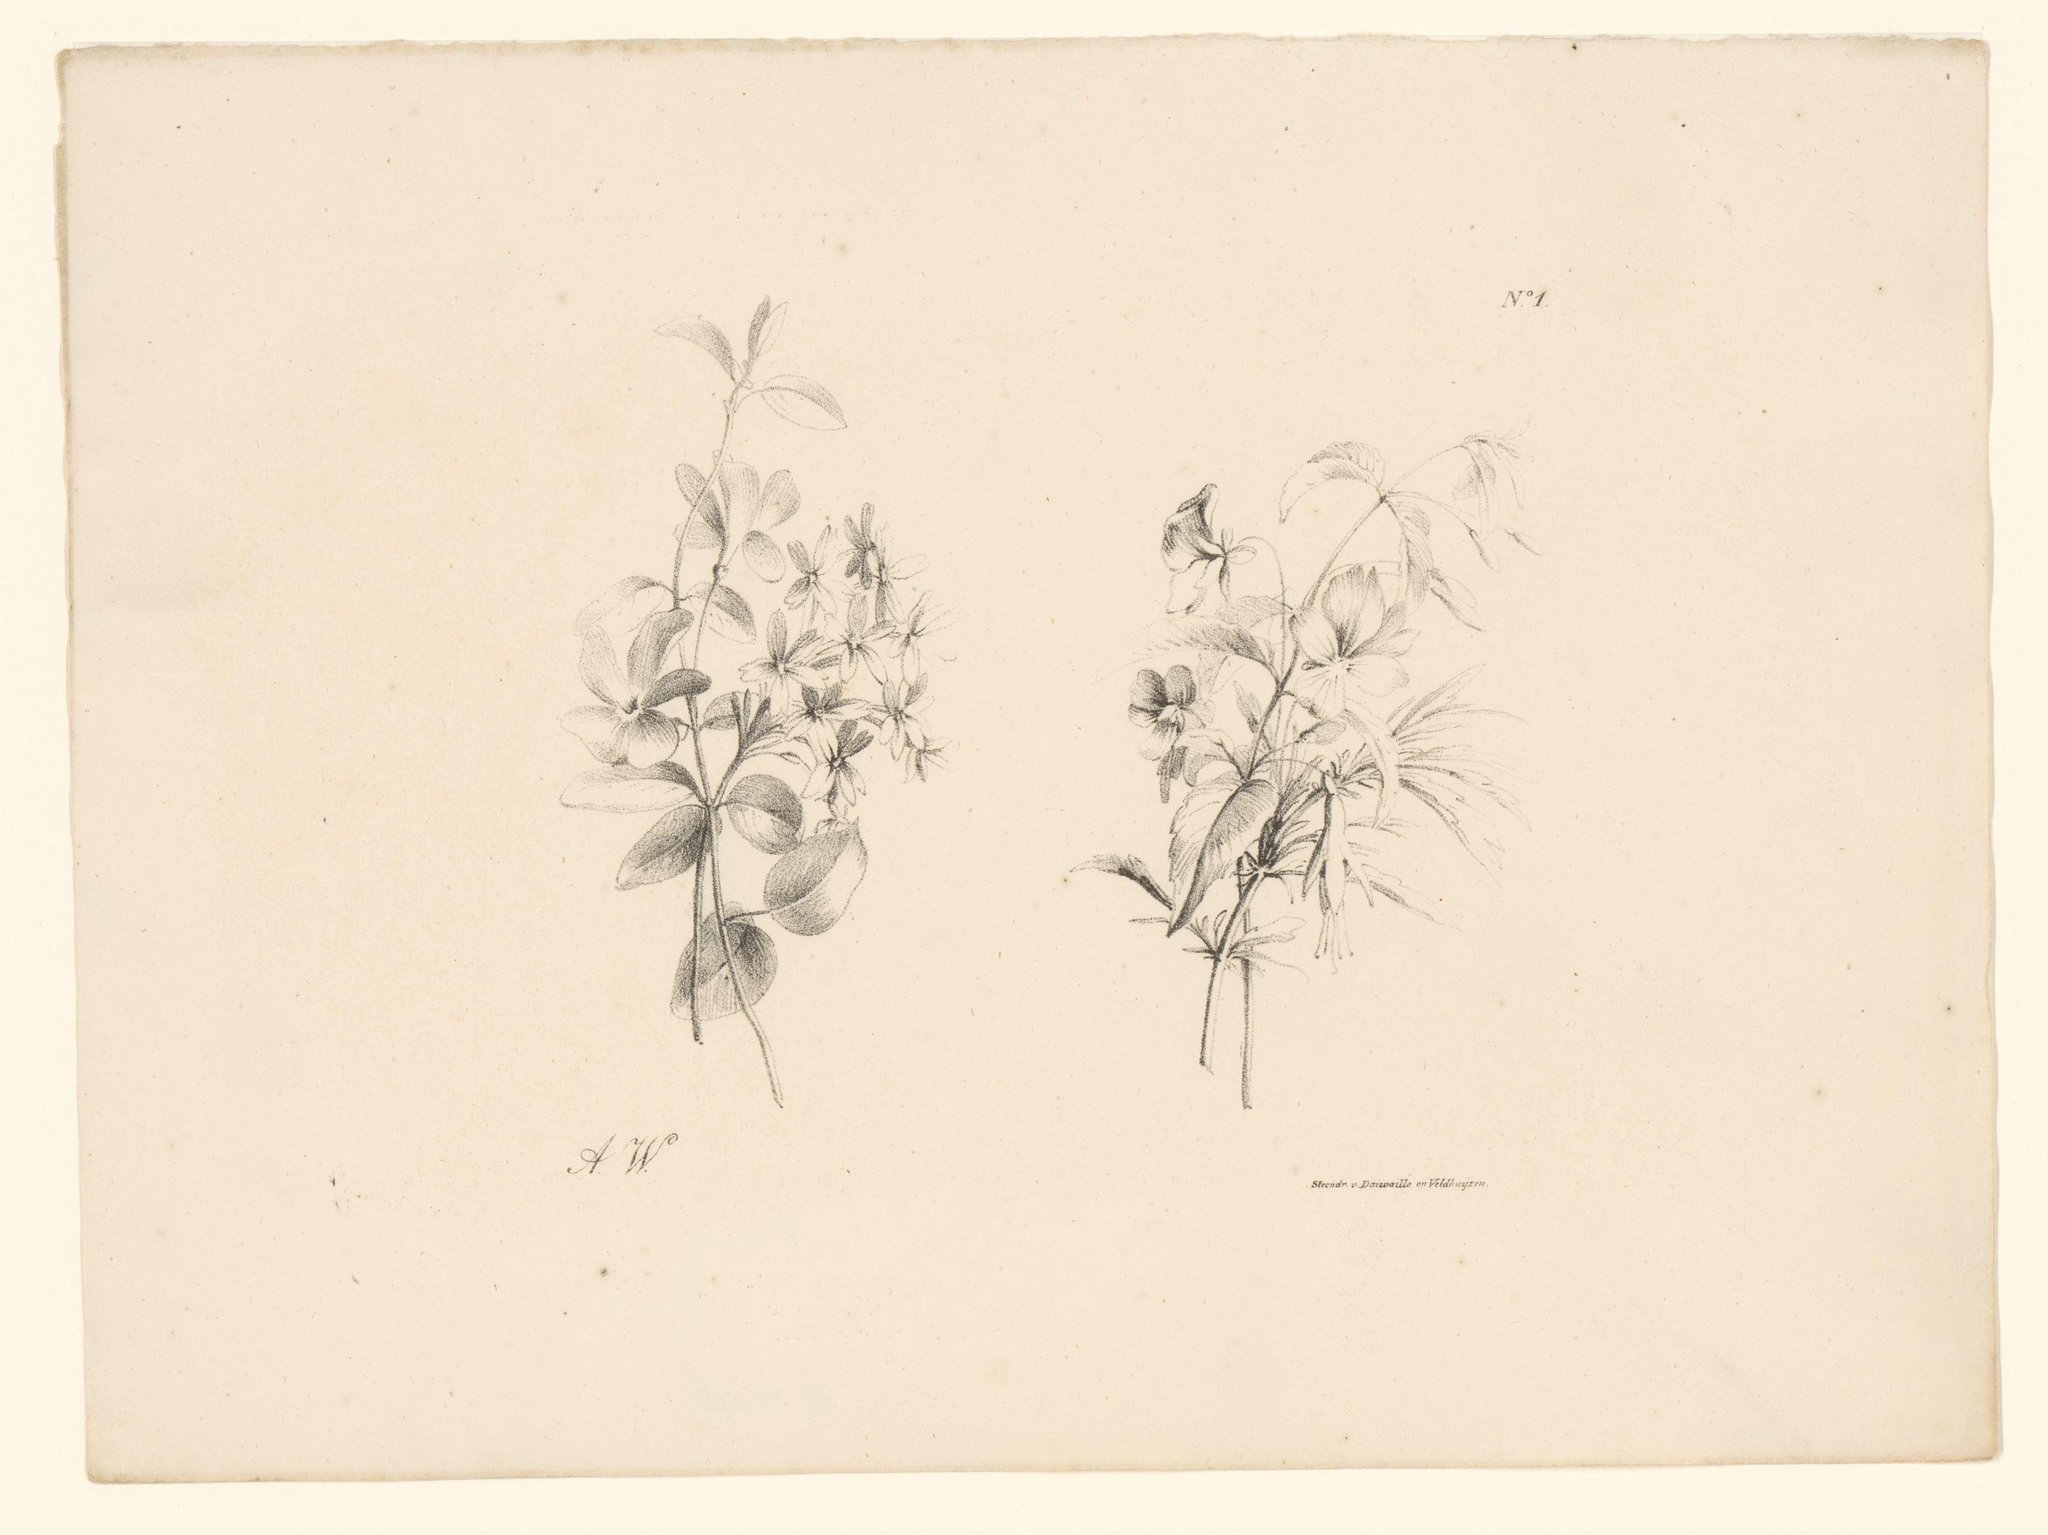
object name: print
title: Bloemen en vruchten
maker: anton weiss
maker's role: draughtsman, print maker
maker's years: 1801-1851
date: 1831-1832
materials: paper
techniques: lithograph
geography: netherlands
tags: flowers